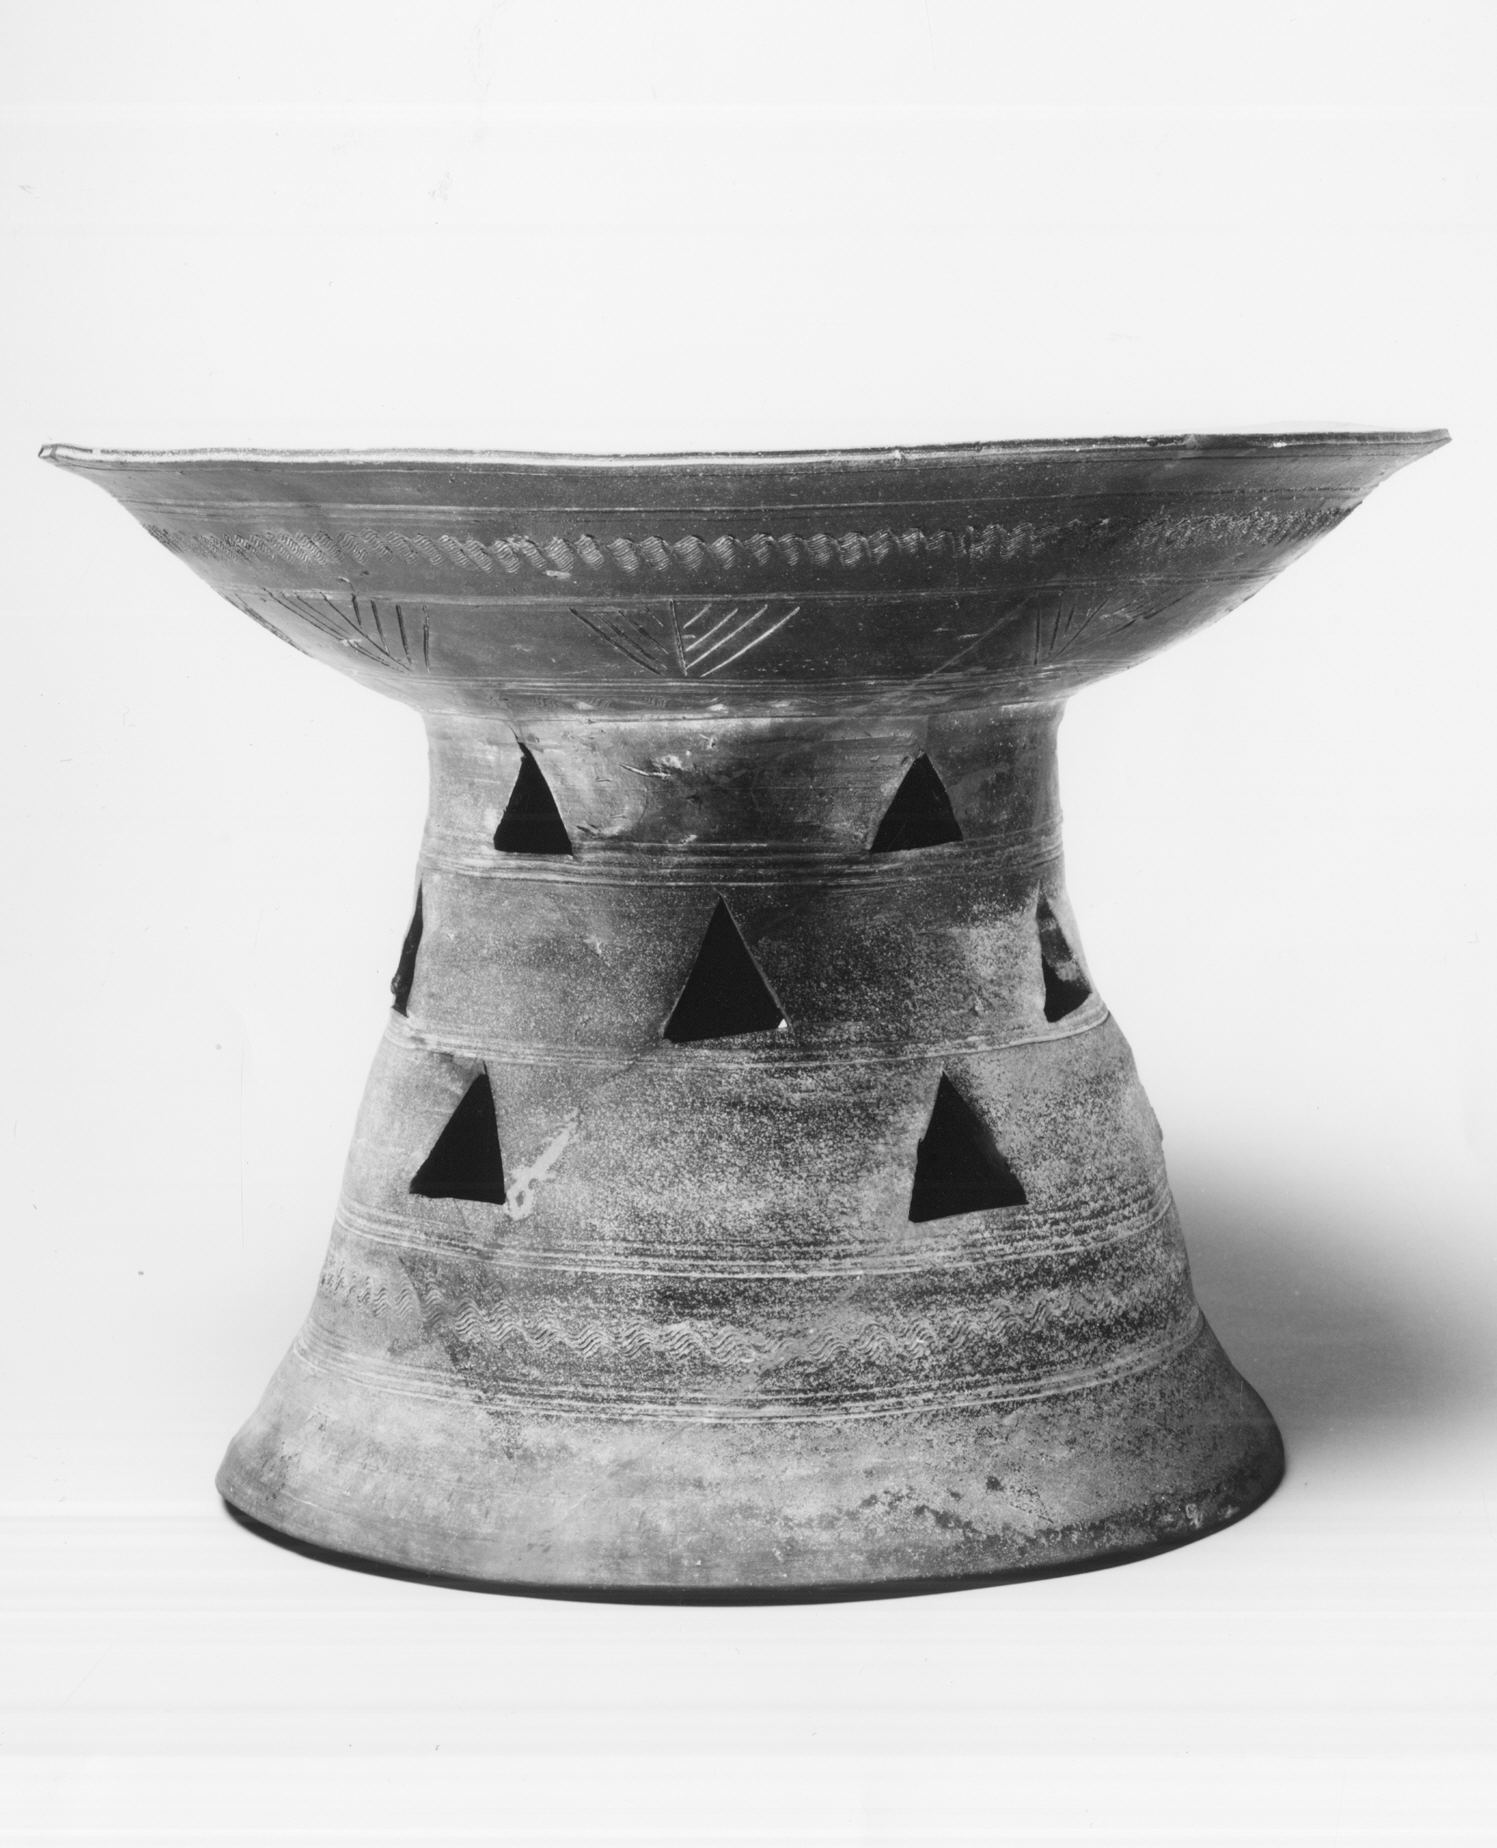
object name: stand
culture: korean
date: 401-500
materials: wood, glaze, stoneware